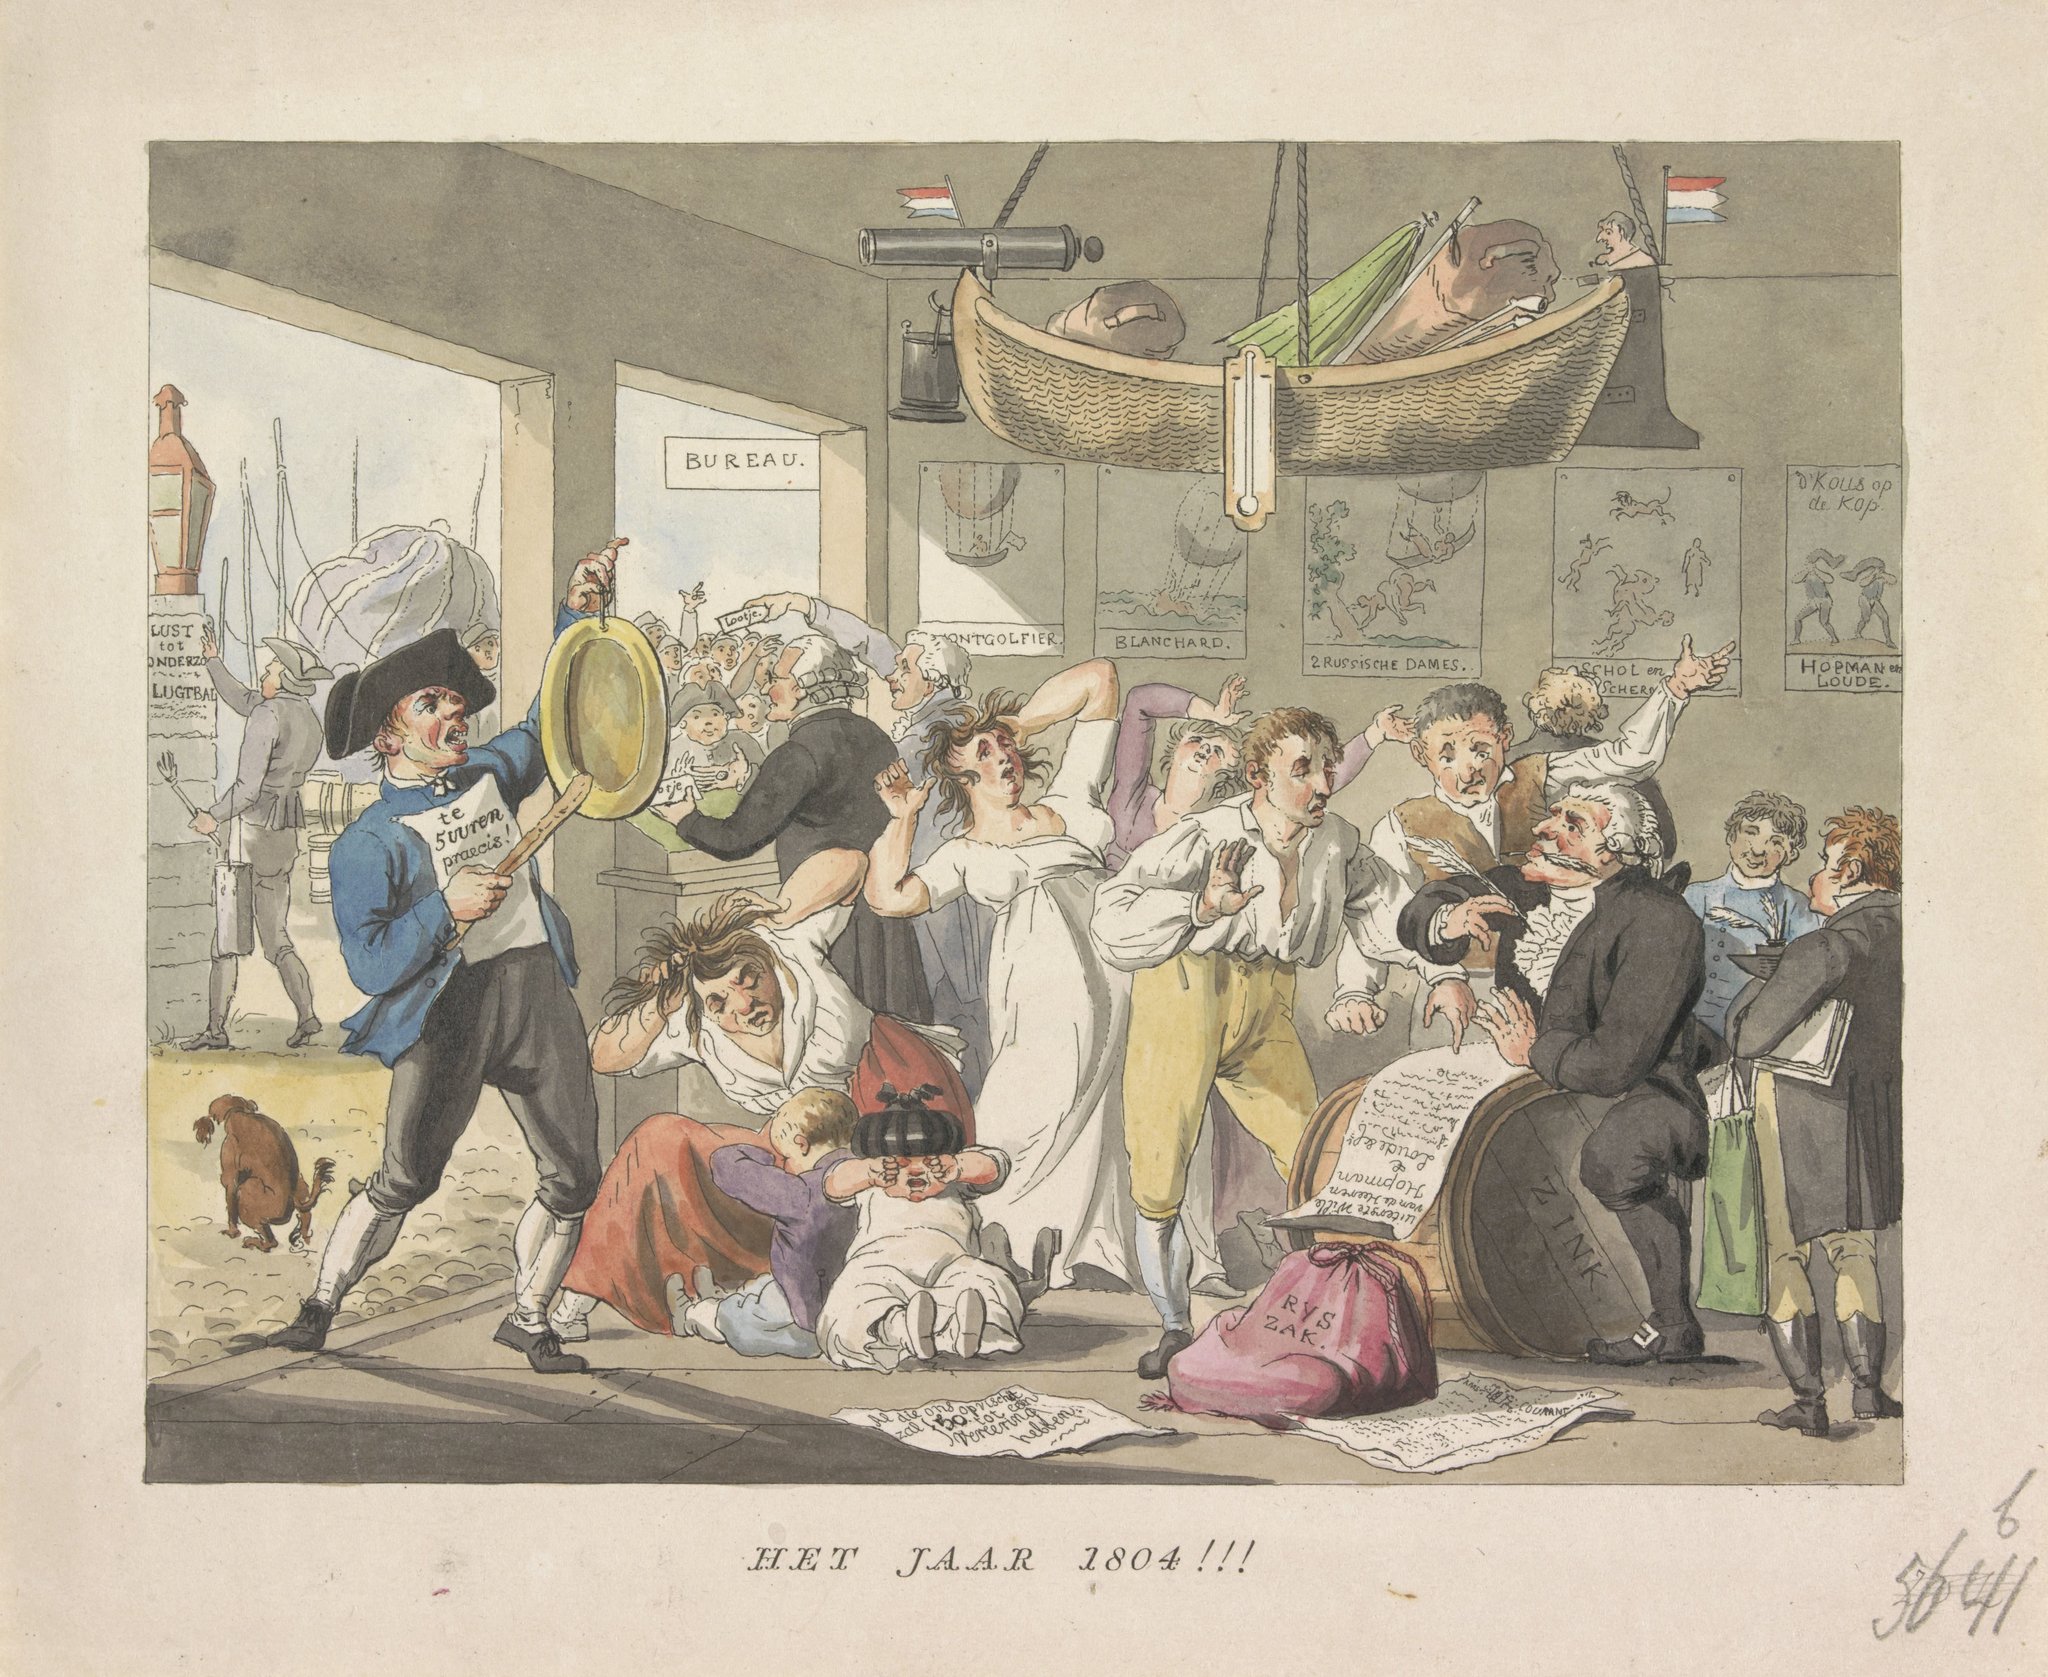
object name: cartoon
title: Het Jaar 1804 !!!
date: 1804-1805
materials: paper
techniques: etching, hand coloring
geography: netherlands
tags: leiden, haarlem, making a testament, balloon flight (sport), notary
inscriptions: inscription: ‘Geschenk van den H: Mazell te 's Hage sept 1885’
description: Chaos in het notariskantoor waar Abraham Hopman en Louis Samuel Loude hun testament laten opmaken. Hun vrouwen trekken zich de haren uit het hoofd, op de vloer huilende kinderen. Op de achtergrond de onsuccesvolle pogingen om de luchtballon met hete lucht te vullen op de Overtoom te Amsterdam op 5 juli 1804. Aan de muren hangen platen van eerdere mislukte vluchten van luchtballons. Aan het plafond hangt een vaartuig uitgerust met kanon, roer, vlaggen en een barometer. Hopman en Loude ondernamen op 5 en 6 juli 1804 pogingen om een reis te maken in een luchtballon genaamd 'Lust tot Onderzoek'. Uiteindelijk is de luchtballon zonder passagiers opgelaten. Zie ook de pendant.